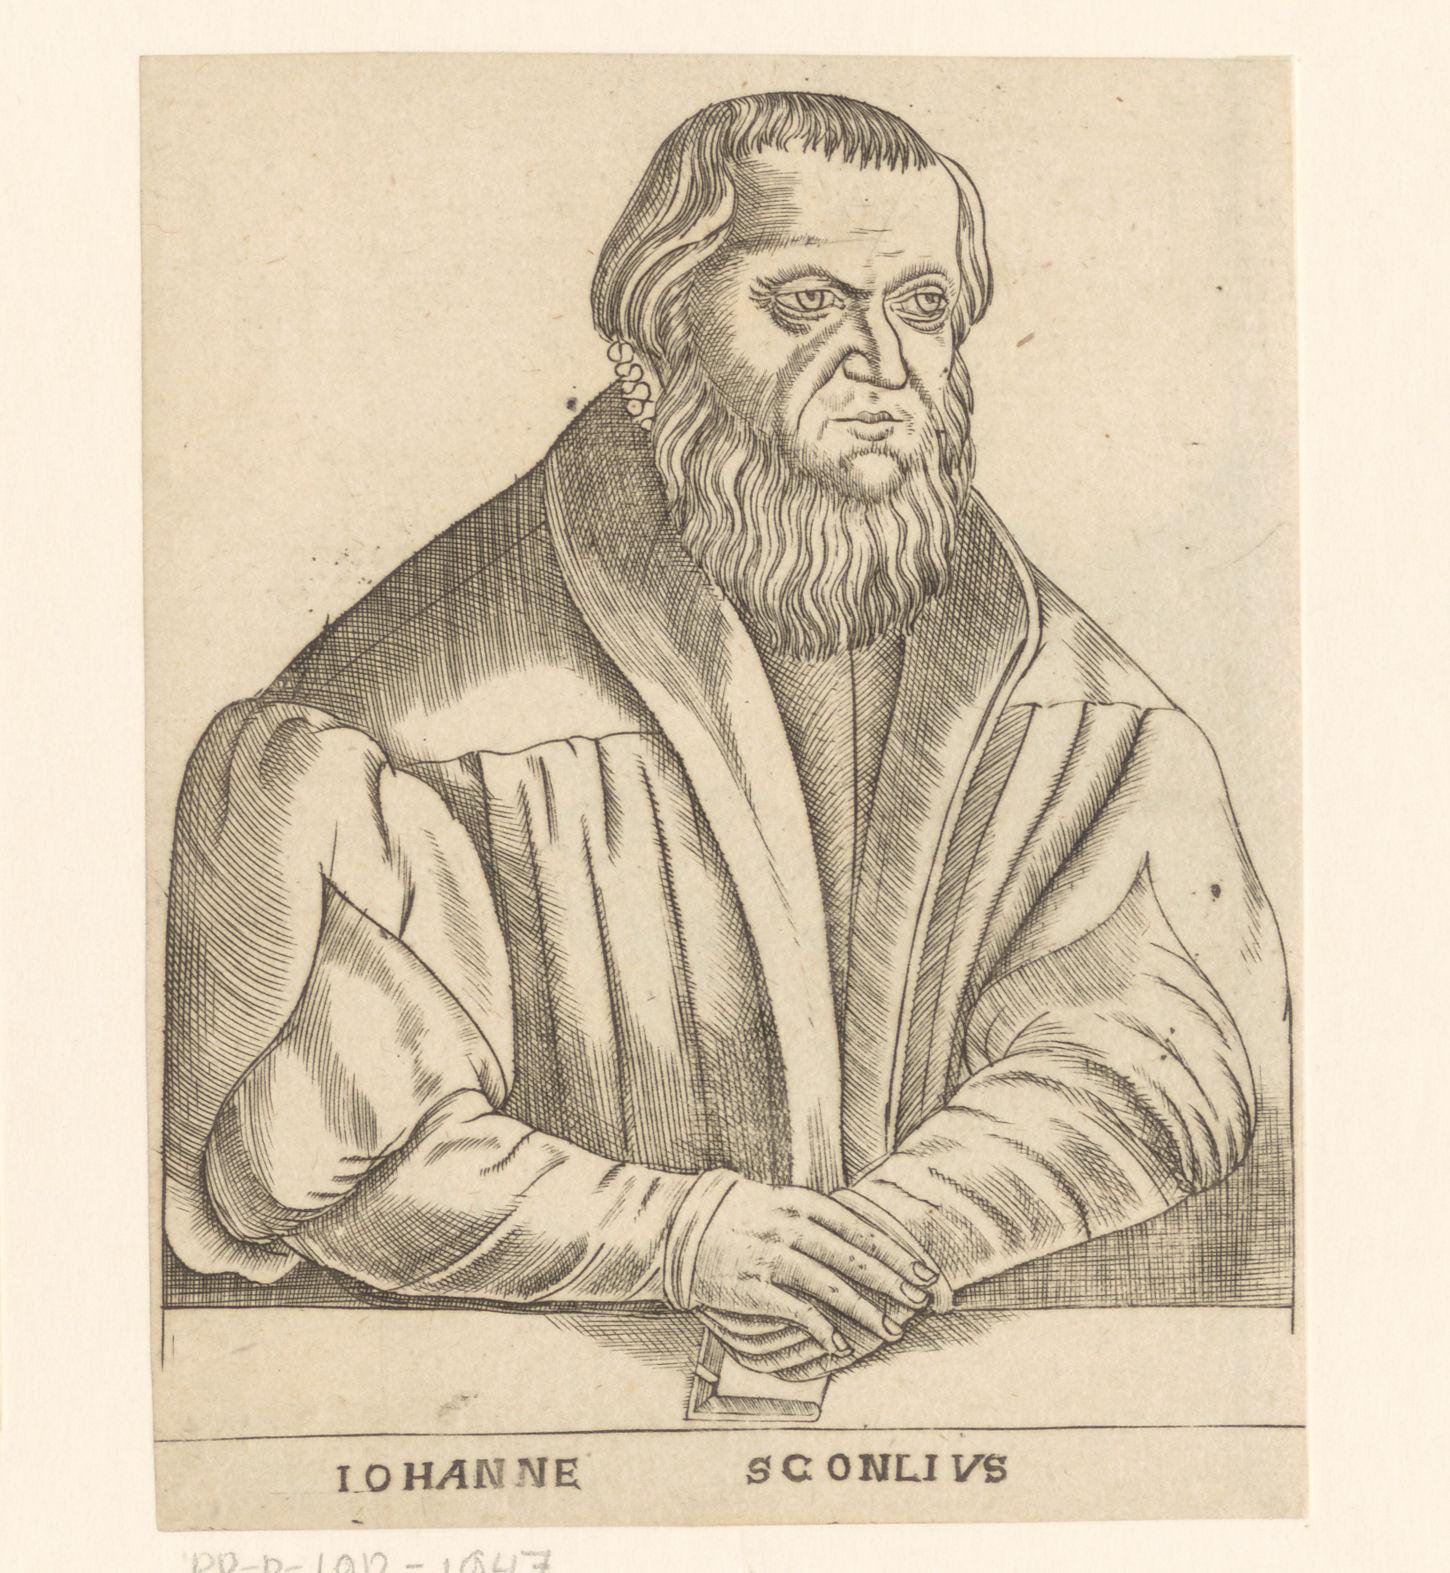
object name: print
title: Portret van Johannes Sconlius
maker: Anonymous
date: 1563-1642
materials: paper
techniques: engraving, etching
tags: theologian, historical persons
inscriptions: collector's mark: Lugt 2228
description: Deze kopie van een prent door Balthasar Jenichen hoort bij een serie portretten van sturende personen tijdens de reformatie, gebruikt in: Agricola, Johann. Bildnüs und Abcontrafactur etzlicher Vornemer Gelerten Menner, durch welche Gott aus sonderbaren gnaden, die rechte reine Warheit des heiligen Evangelii, zu diesen unsern und beschrieben (...). Dresden: Gimmel Bergen, 1588.